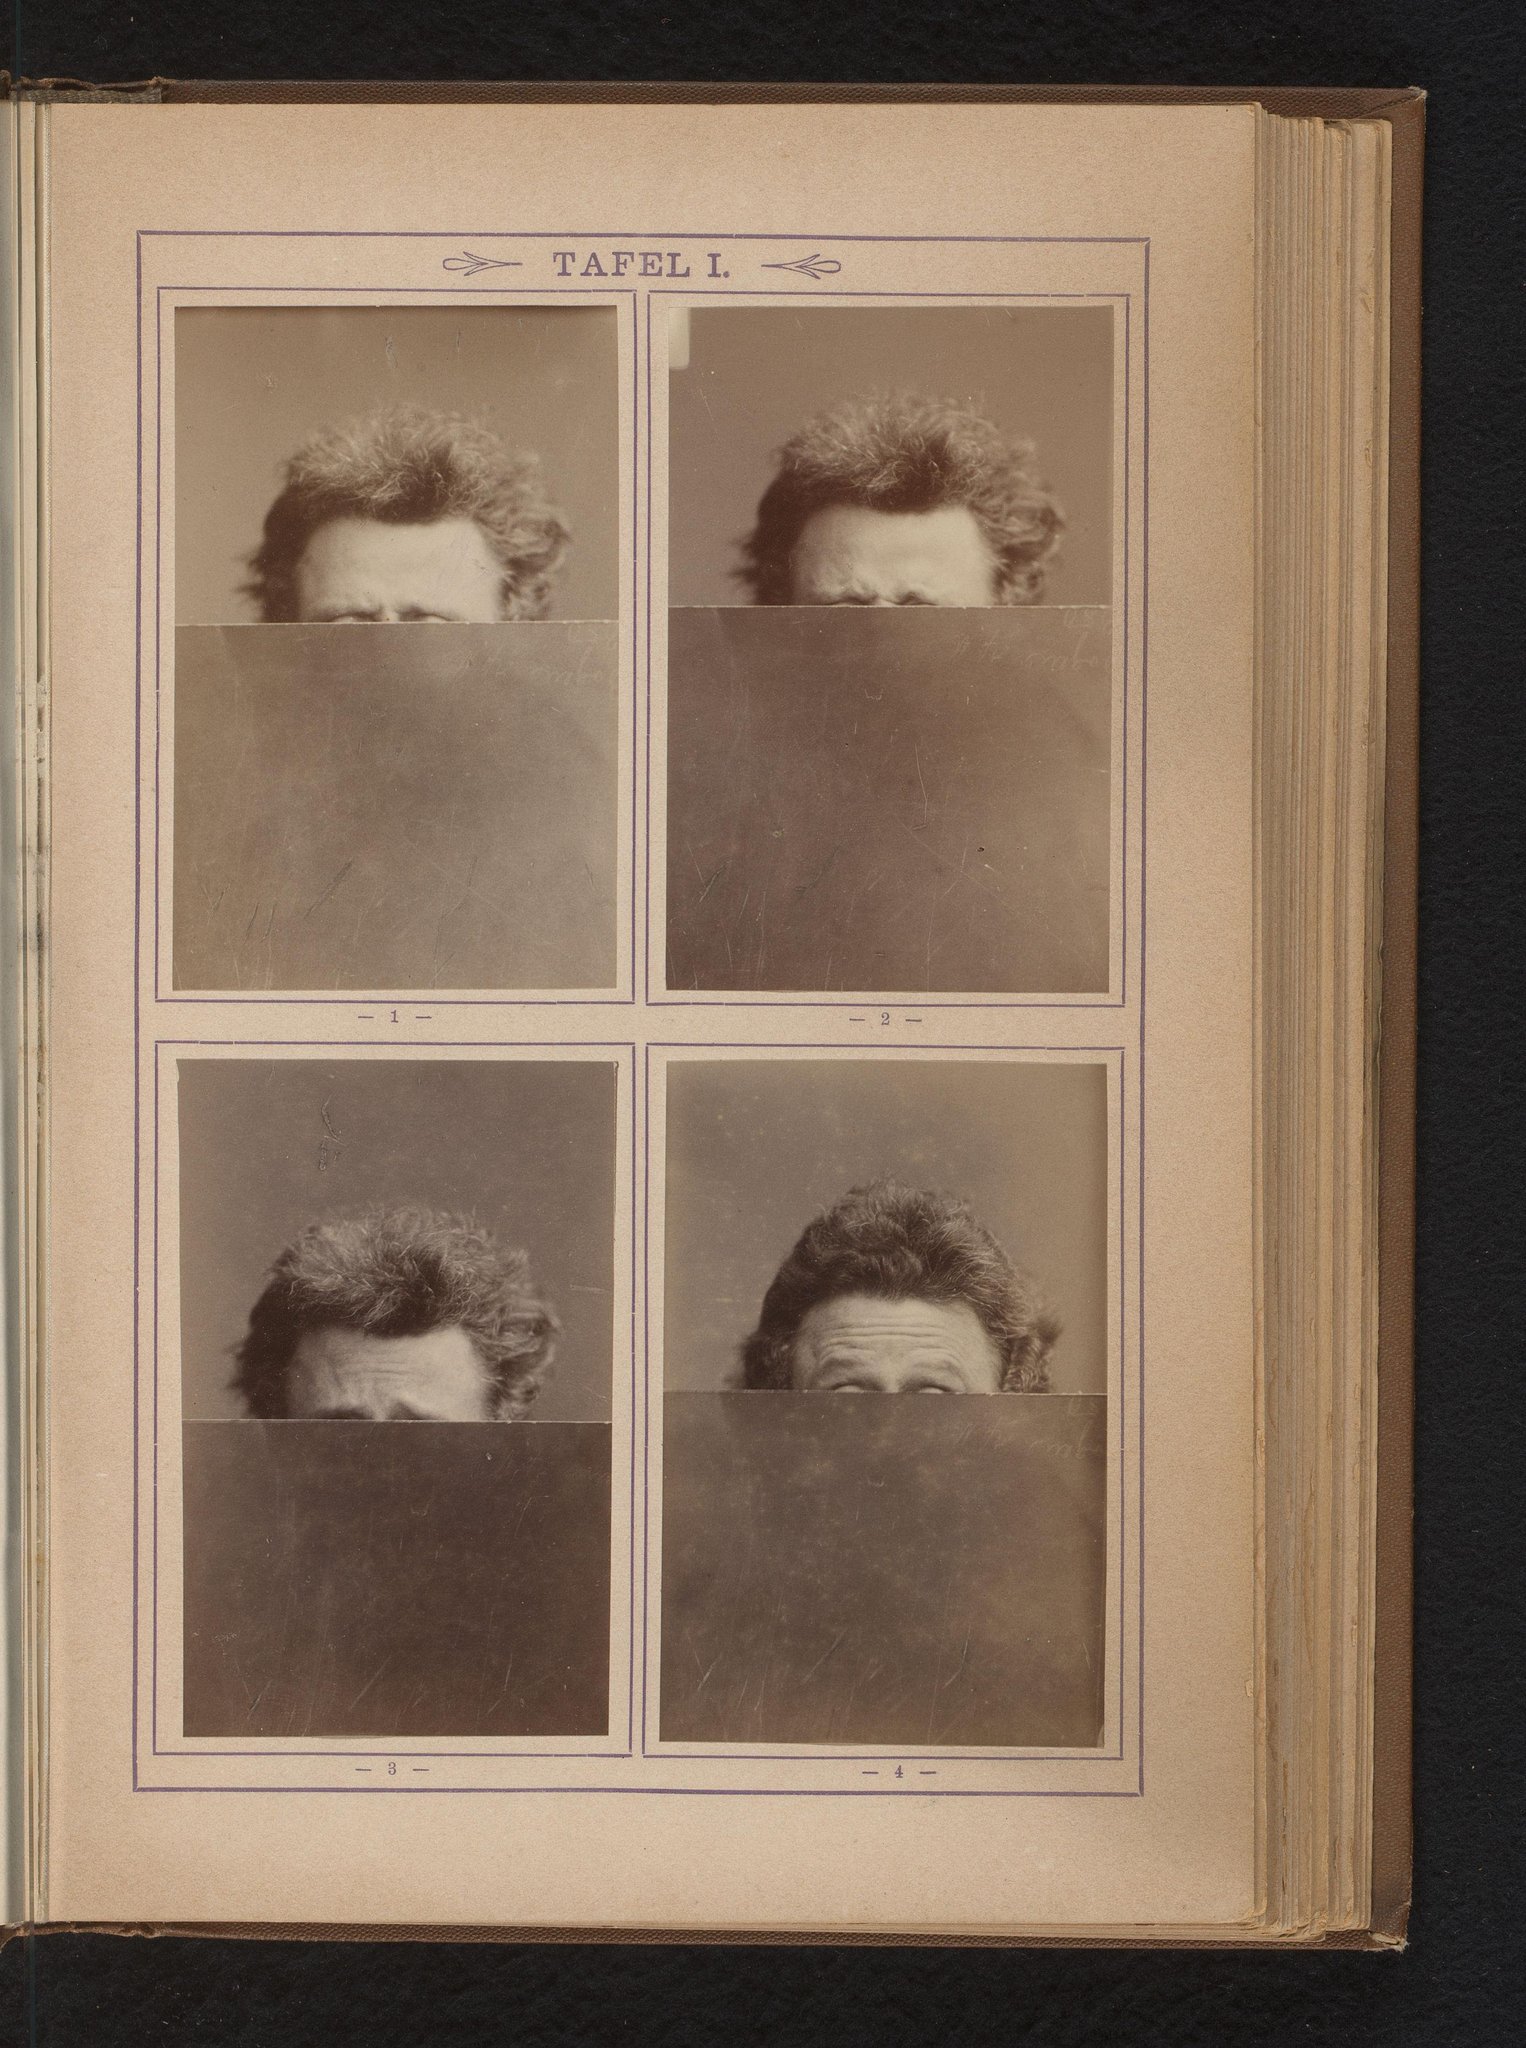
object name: page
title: Vier voorhoofden van een man bij nadenken, woede, huilen en verbazing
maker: nicola tonger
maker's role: fotograaf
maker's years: 1846-1917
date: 1881-1886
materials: paper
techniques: albumen print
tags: face, morphology of facial expression ~ forehead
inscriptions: number: ‘TAFEL I.’, number: ‘1 - 4’